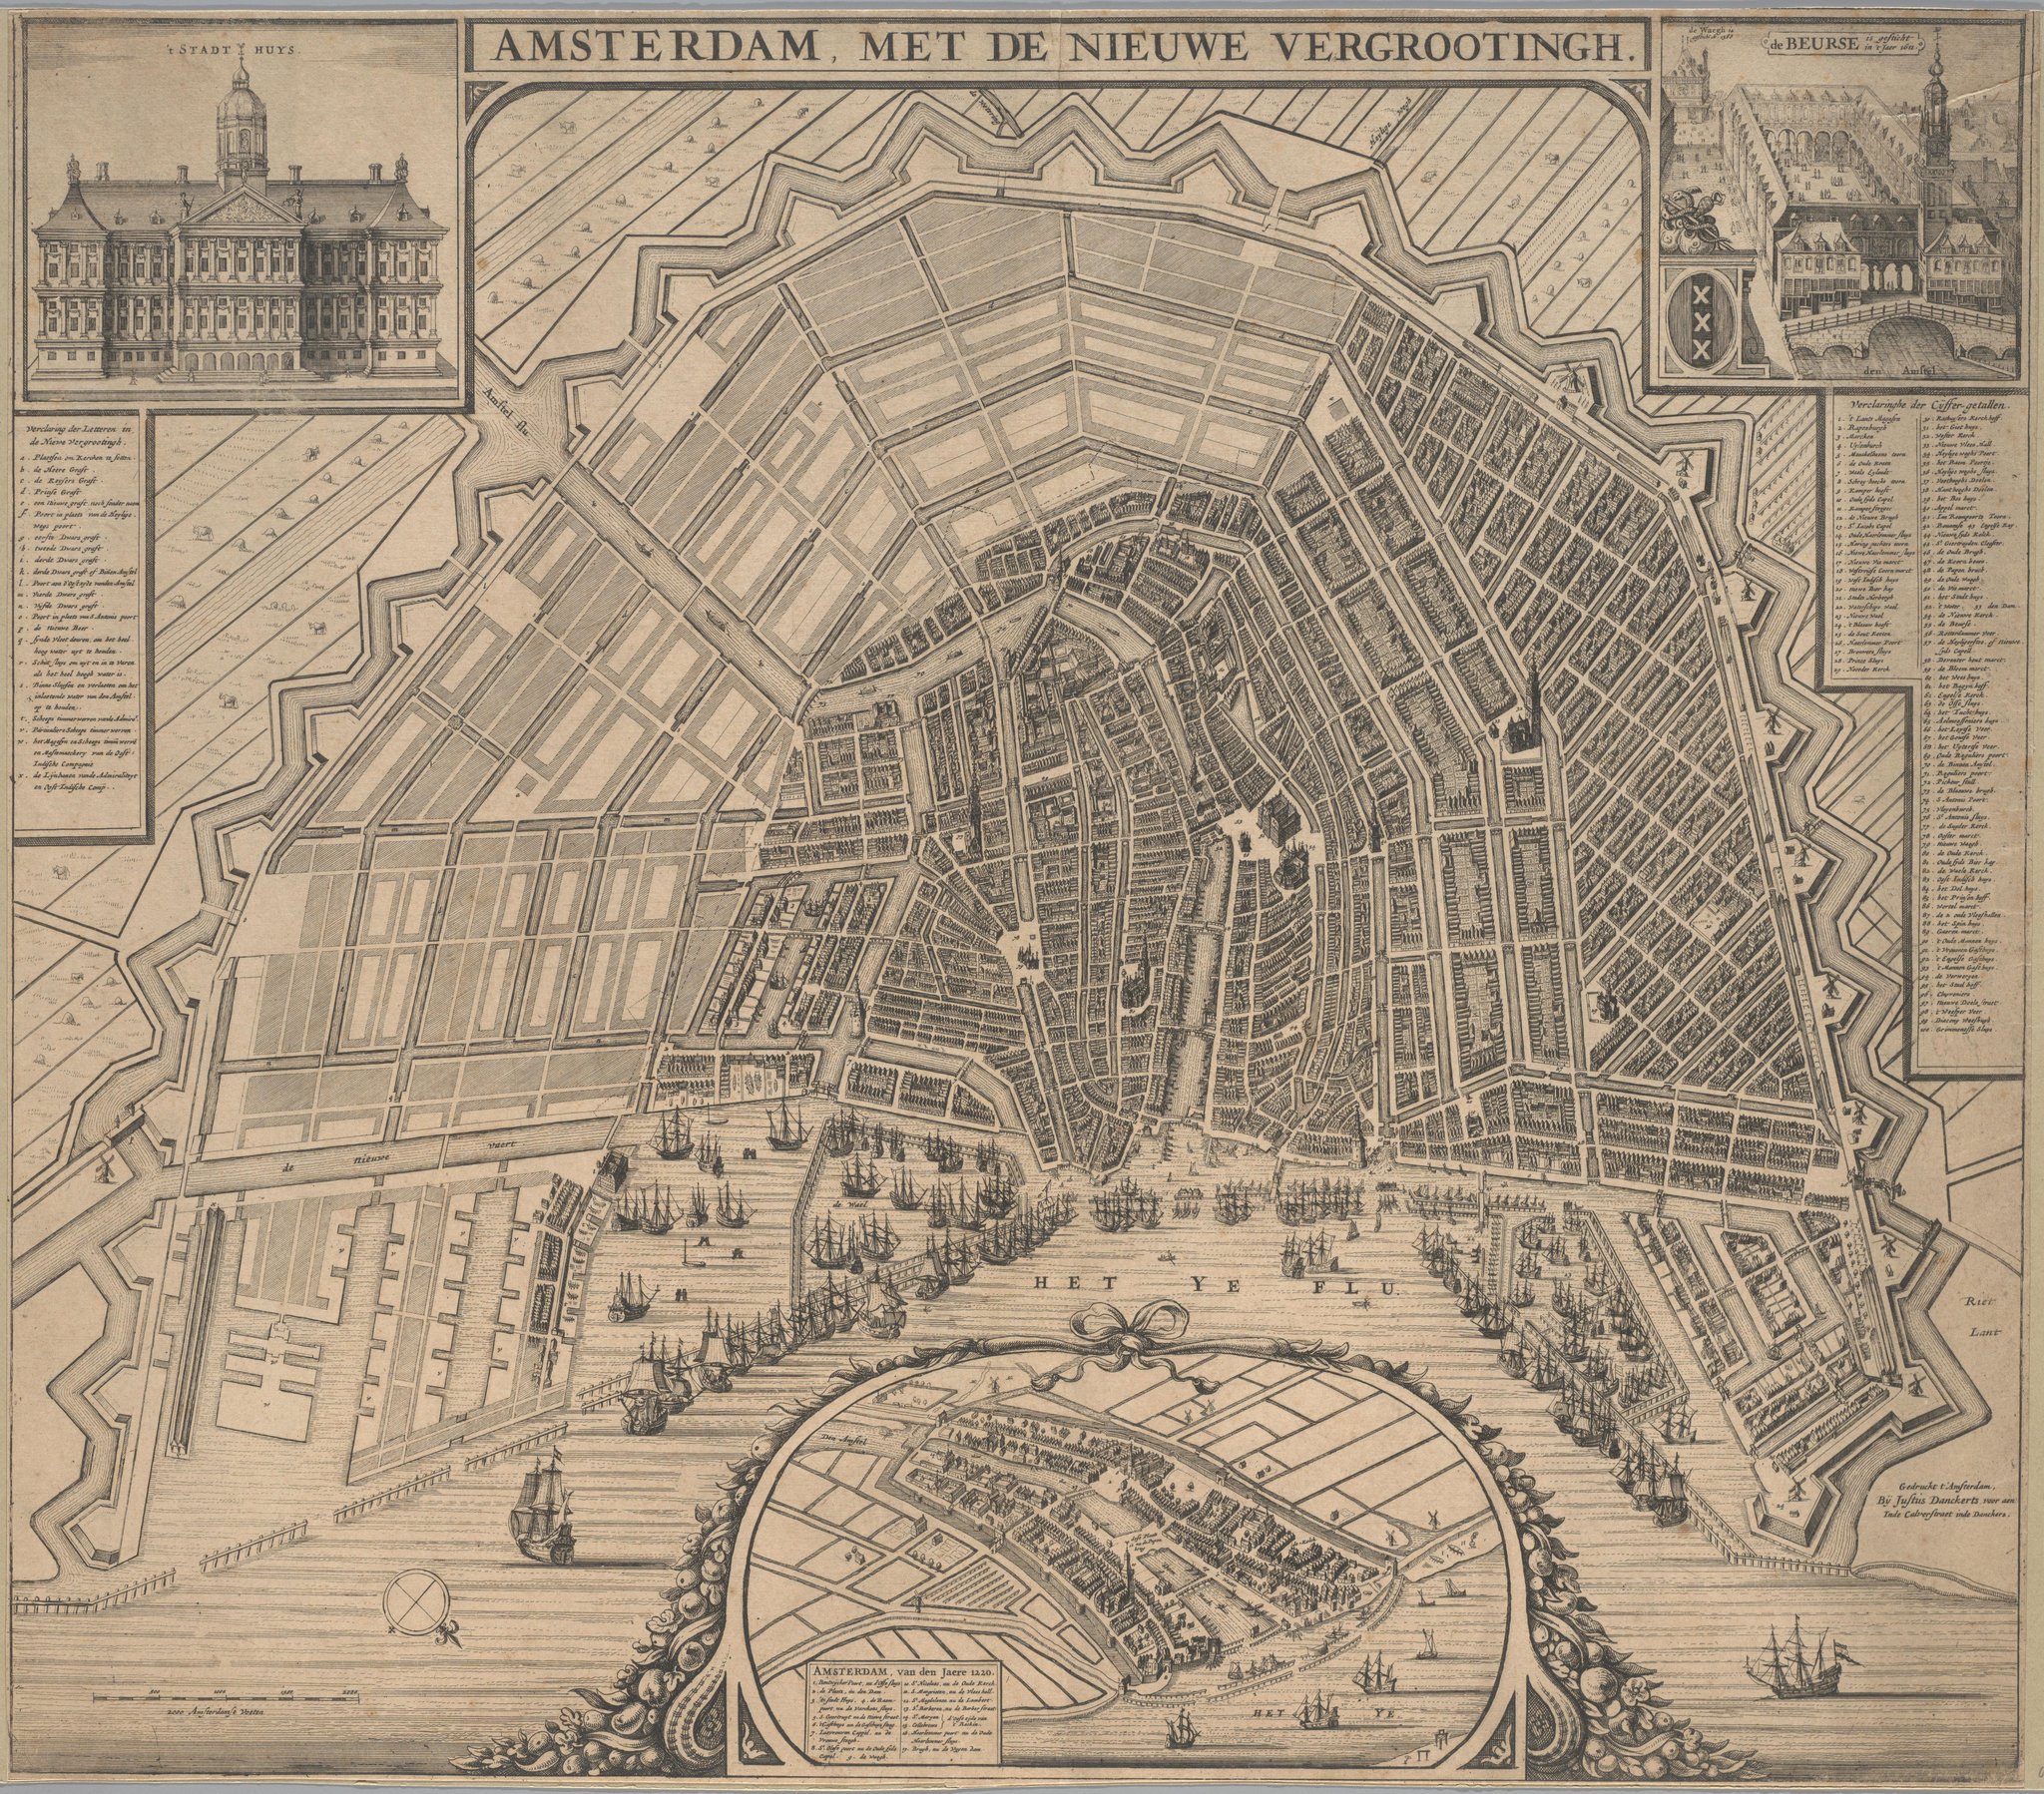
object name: map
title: Amsterdam, met de nieuwe vergrootingh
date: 1662-1663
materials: paper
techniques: engraving, etching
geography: northern netherlands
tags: coat of arms (as symbol of the state, etc.) (+ city; municipal), stock exchange, stock-market, townhall, maps of cities, amsterdam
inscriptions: collector's mark: Lugt 1641b